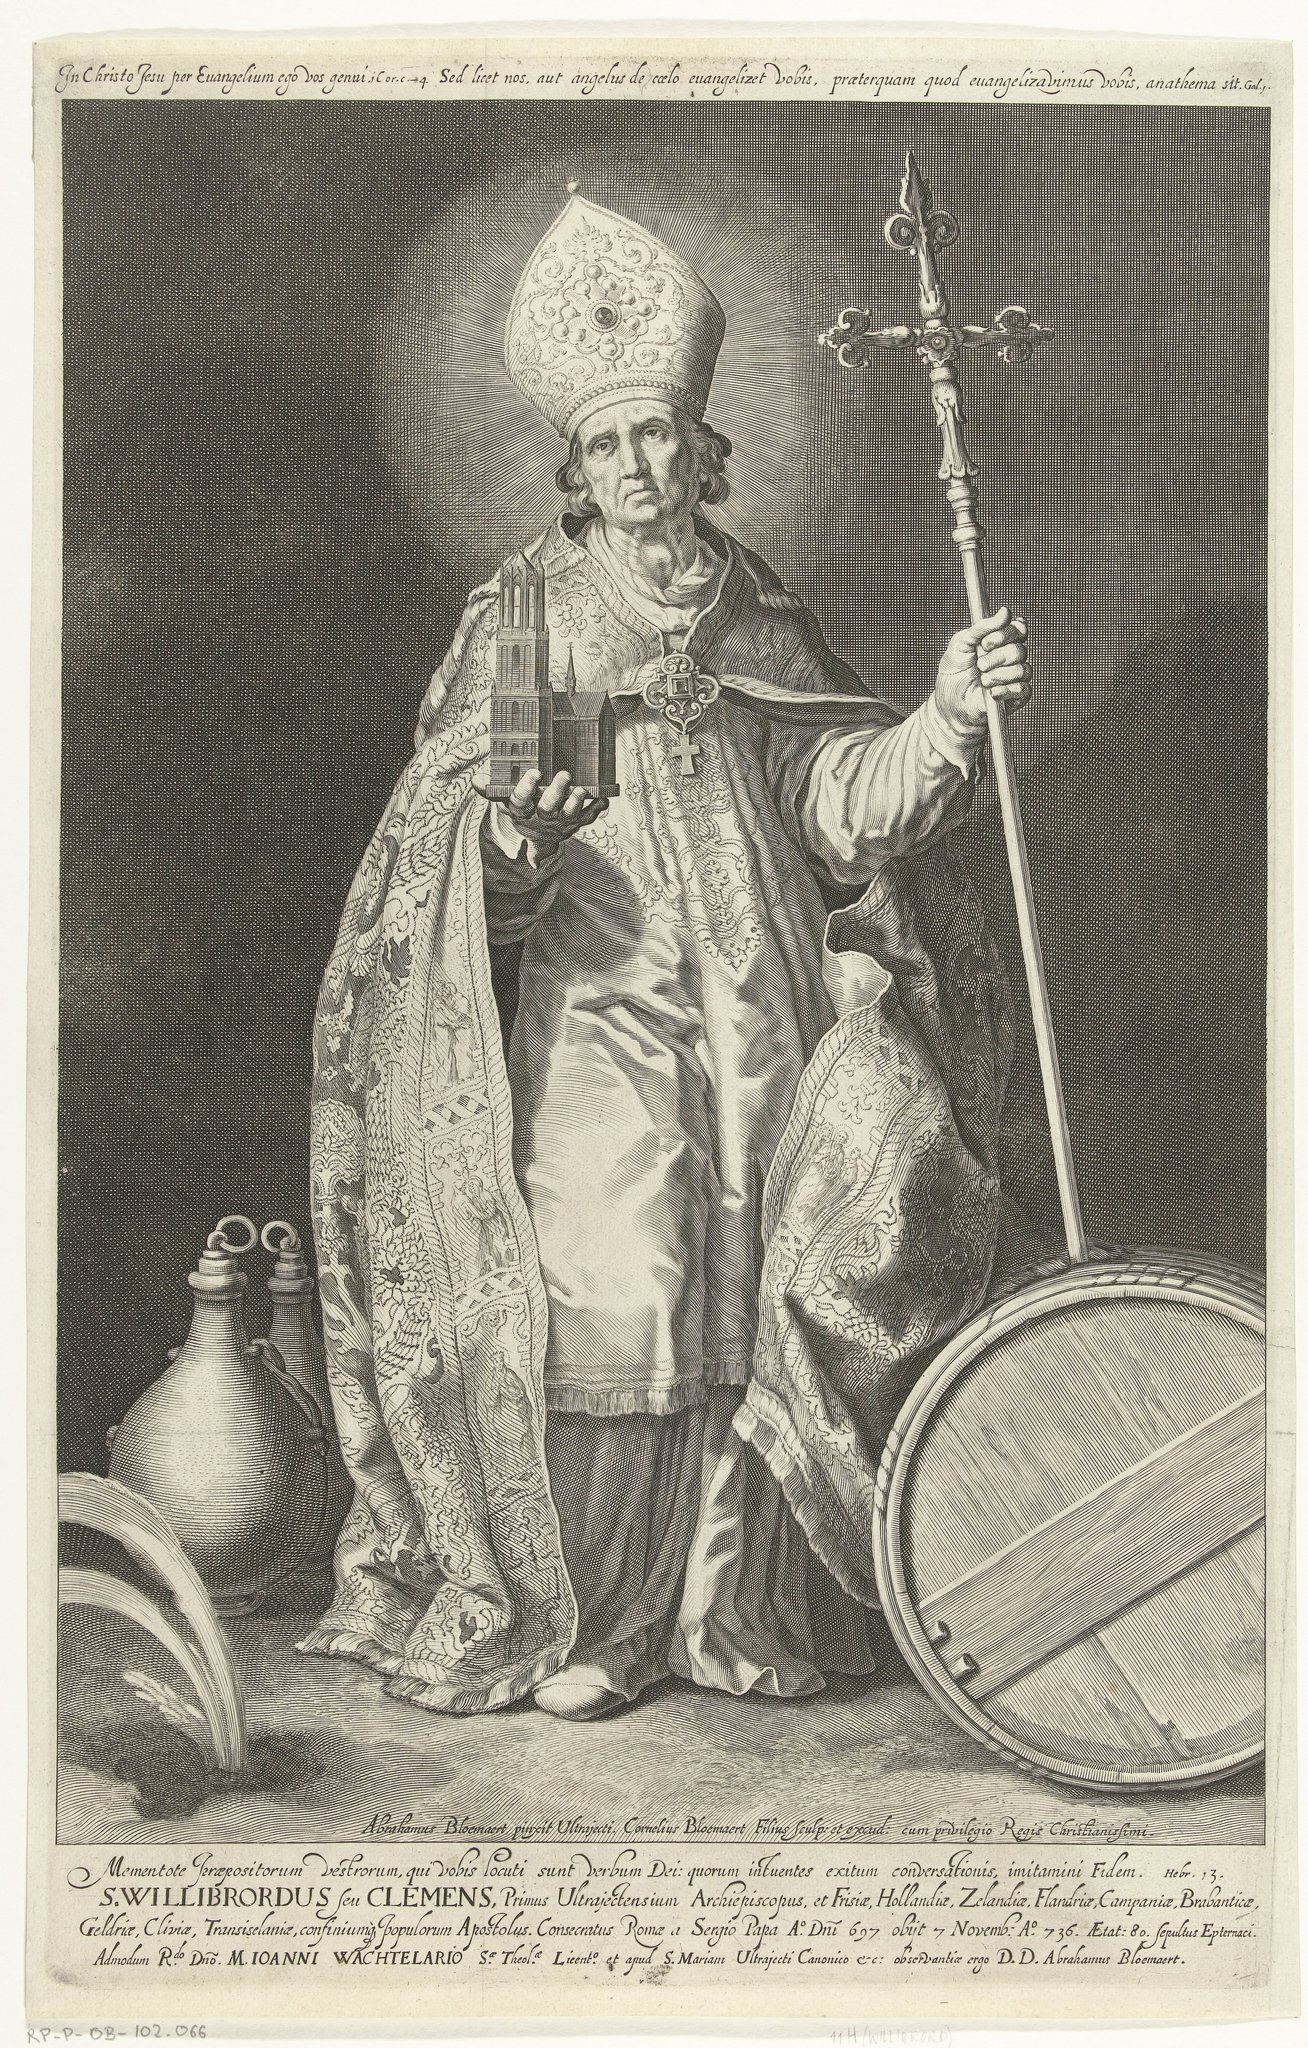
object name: print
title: De heilige Willibrordus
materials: paper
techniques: engraving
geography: utrecht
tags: the 'apostle of frisia' and archbishop of utrecht, willibrord (of echternach); possible attributes: cask (barrel), well (fountain), child (on a book), model of church, stone bottles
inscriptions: collector's mark: Lugt 2221, collector's mark: Lugt 2228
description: Willibrordus, de eerste bisschop van Utrecht, in bisschopsgewaad met mijter en staf. Hij draagt een model van de dom van Utrecht in zijn hand. Het wijnvat en de kruiken verwijzen naar een wonder dat in het klooster Echternach onder zijn bewind gebeurde. Prent uit een serie van twaalf prenten met prelaten en bisschoppen van Utrecht door Cornelis en Frederick Bloemaert.